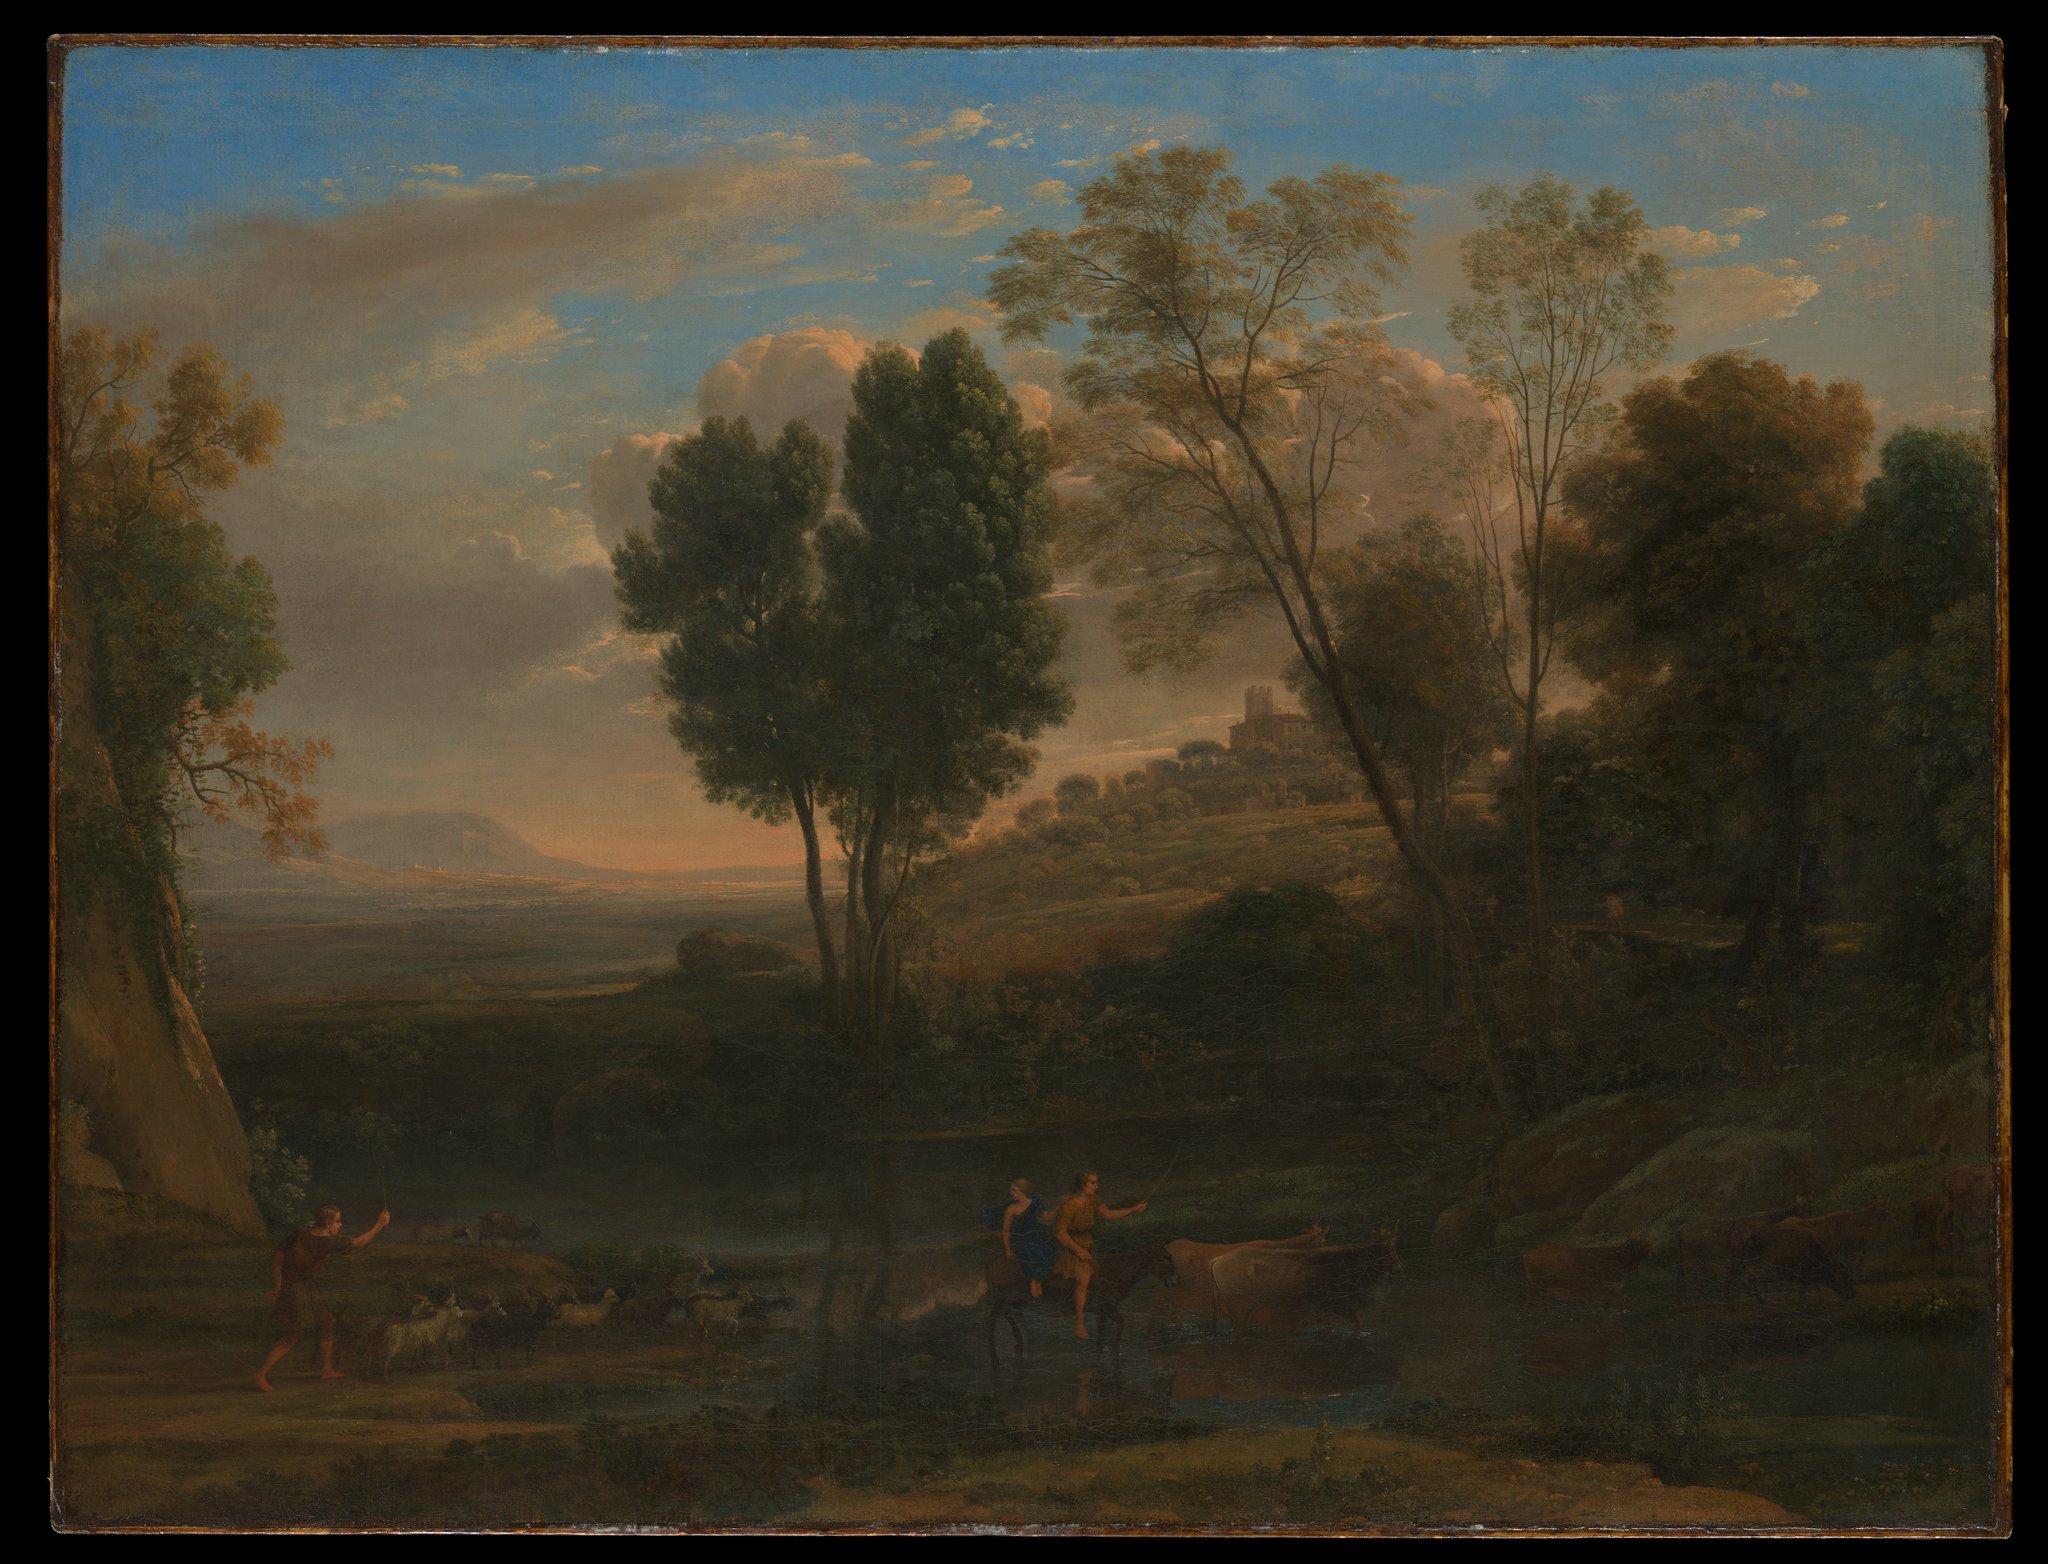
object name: painting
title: Sunrise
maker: claude lorrain (claude gellée)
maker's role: artist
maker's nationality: french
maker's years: 1604-1682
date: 1646-1647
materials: canvas, oil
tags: human figures,cows,landscapes,dawn